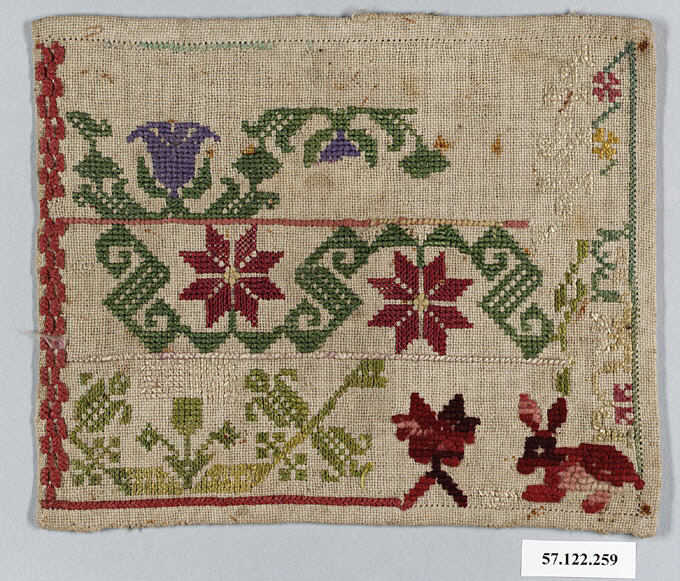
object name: sampler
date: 1801-1900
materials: cotton, silk, wool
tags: animals,flowers